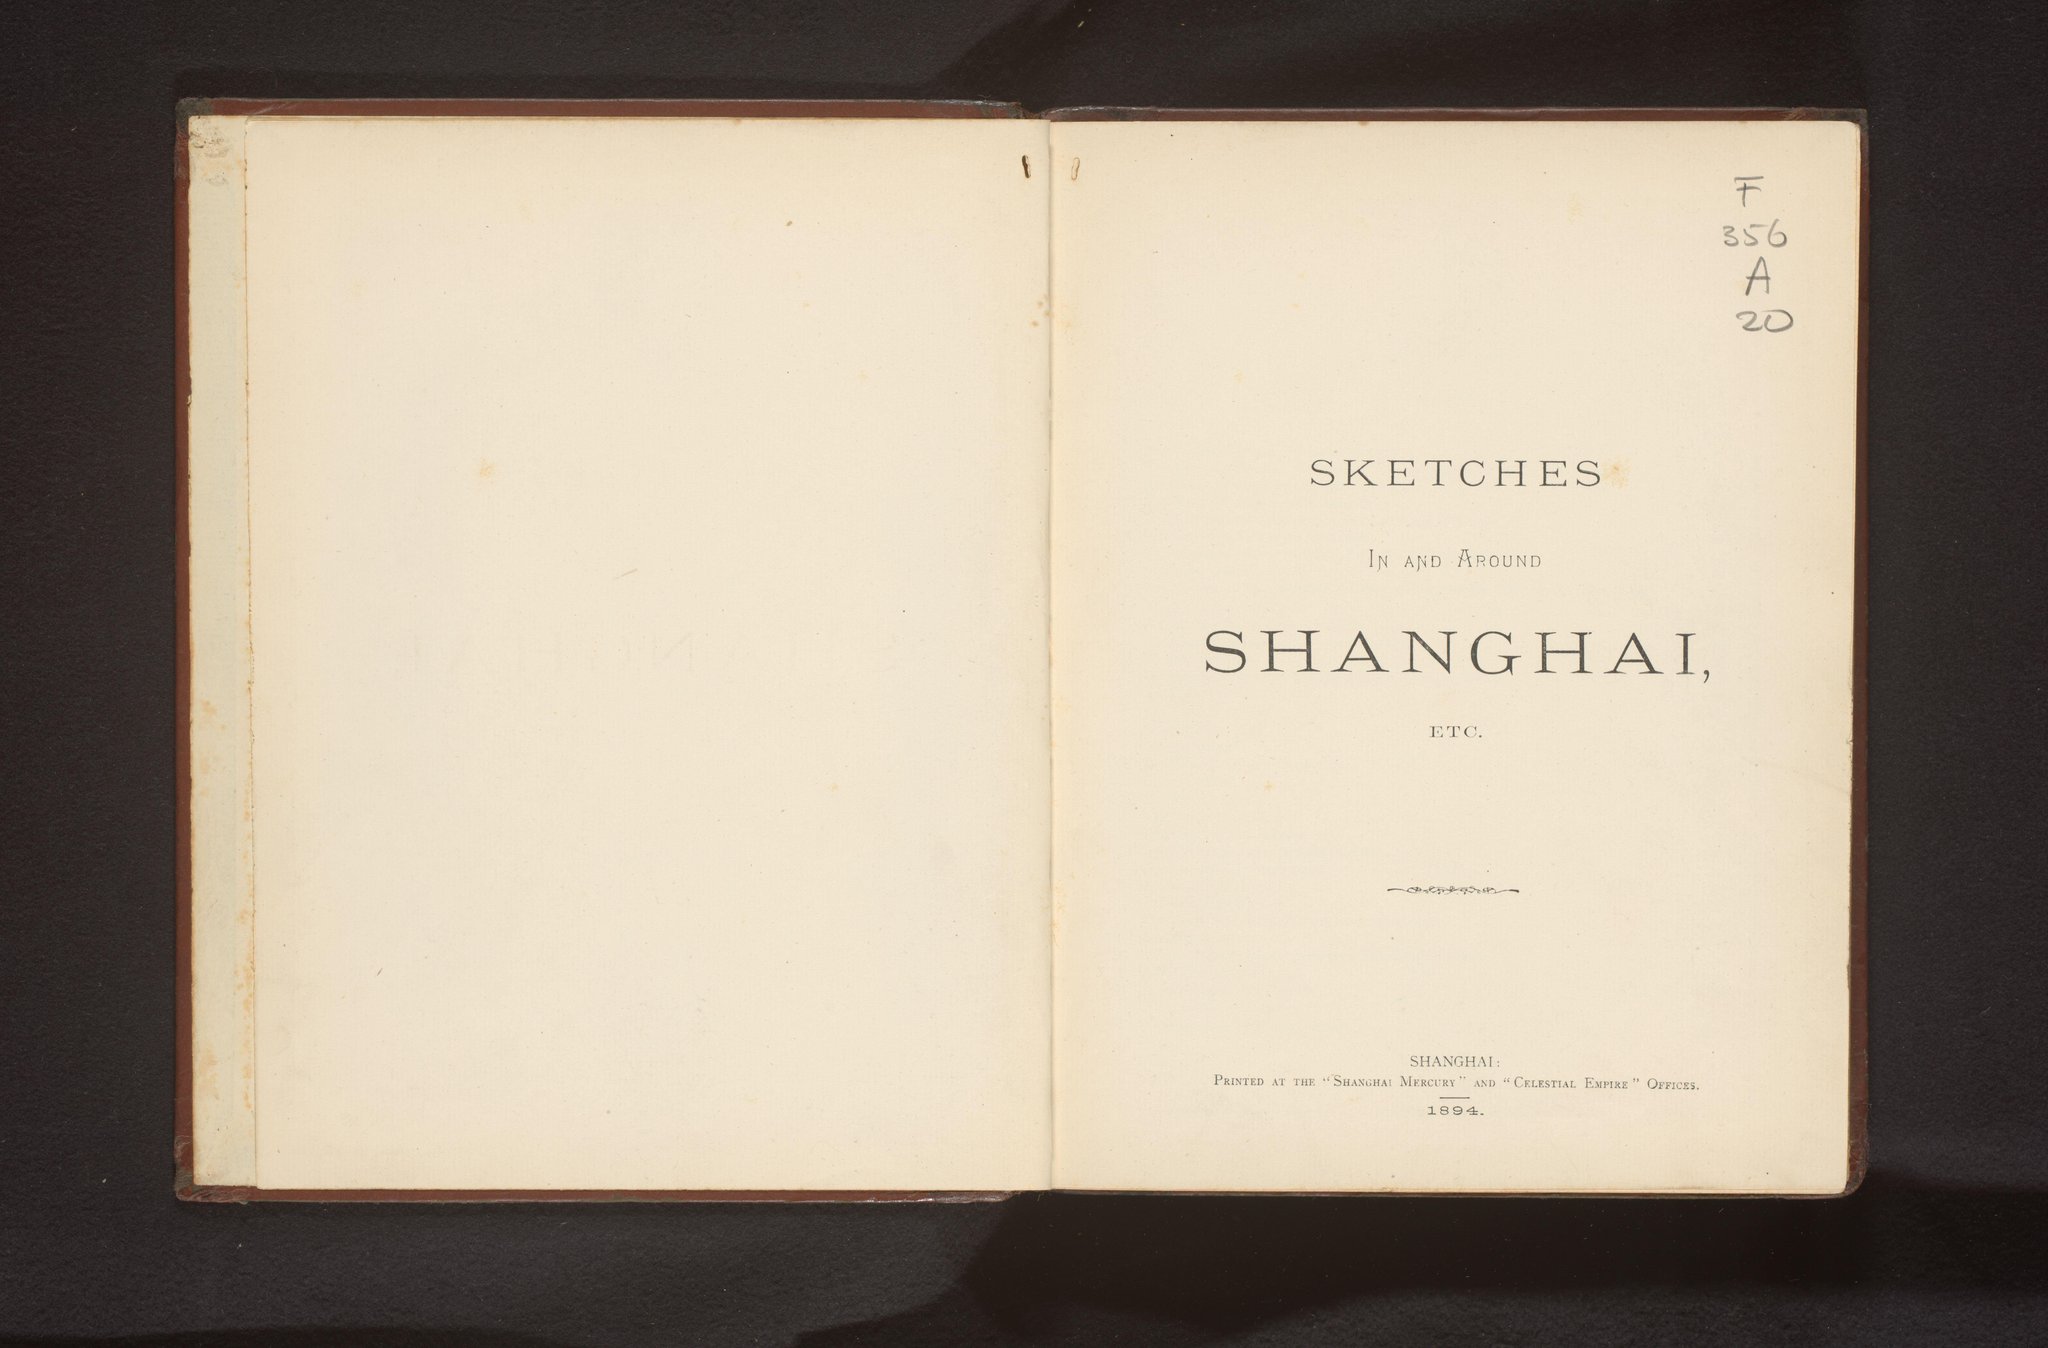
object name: book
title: Sketches in and around Shanghai, etc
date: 1894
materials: cardboard, paper, photographic support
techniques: albumen print, gelatin silver print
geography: shanghai